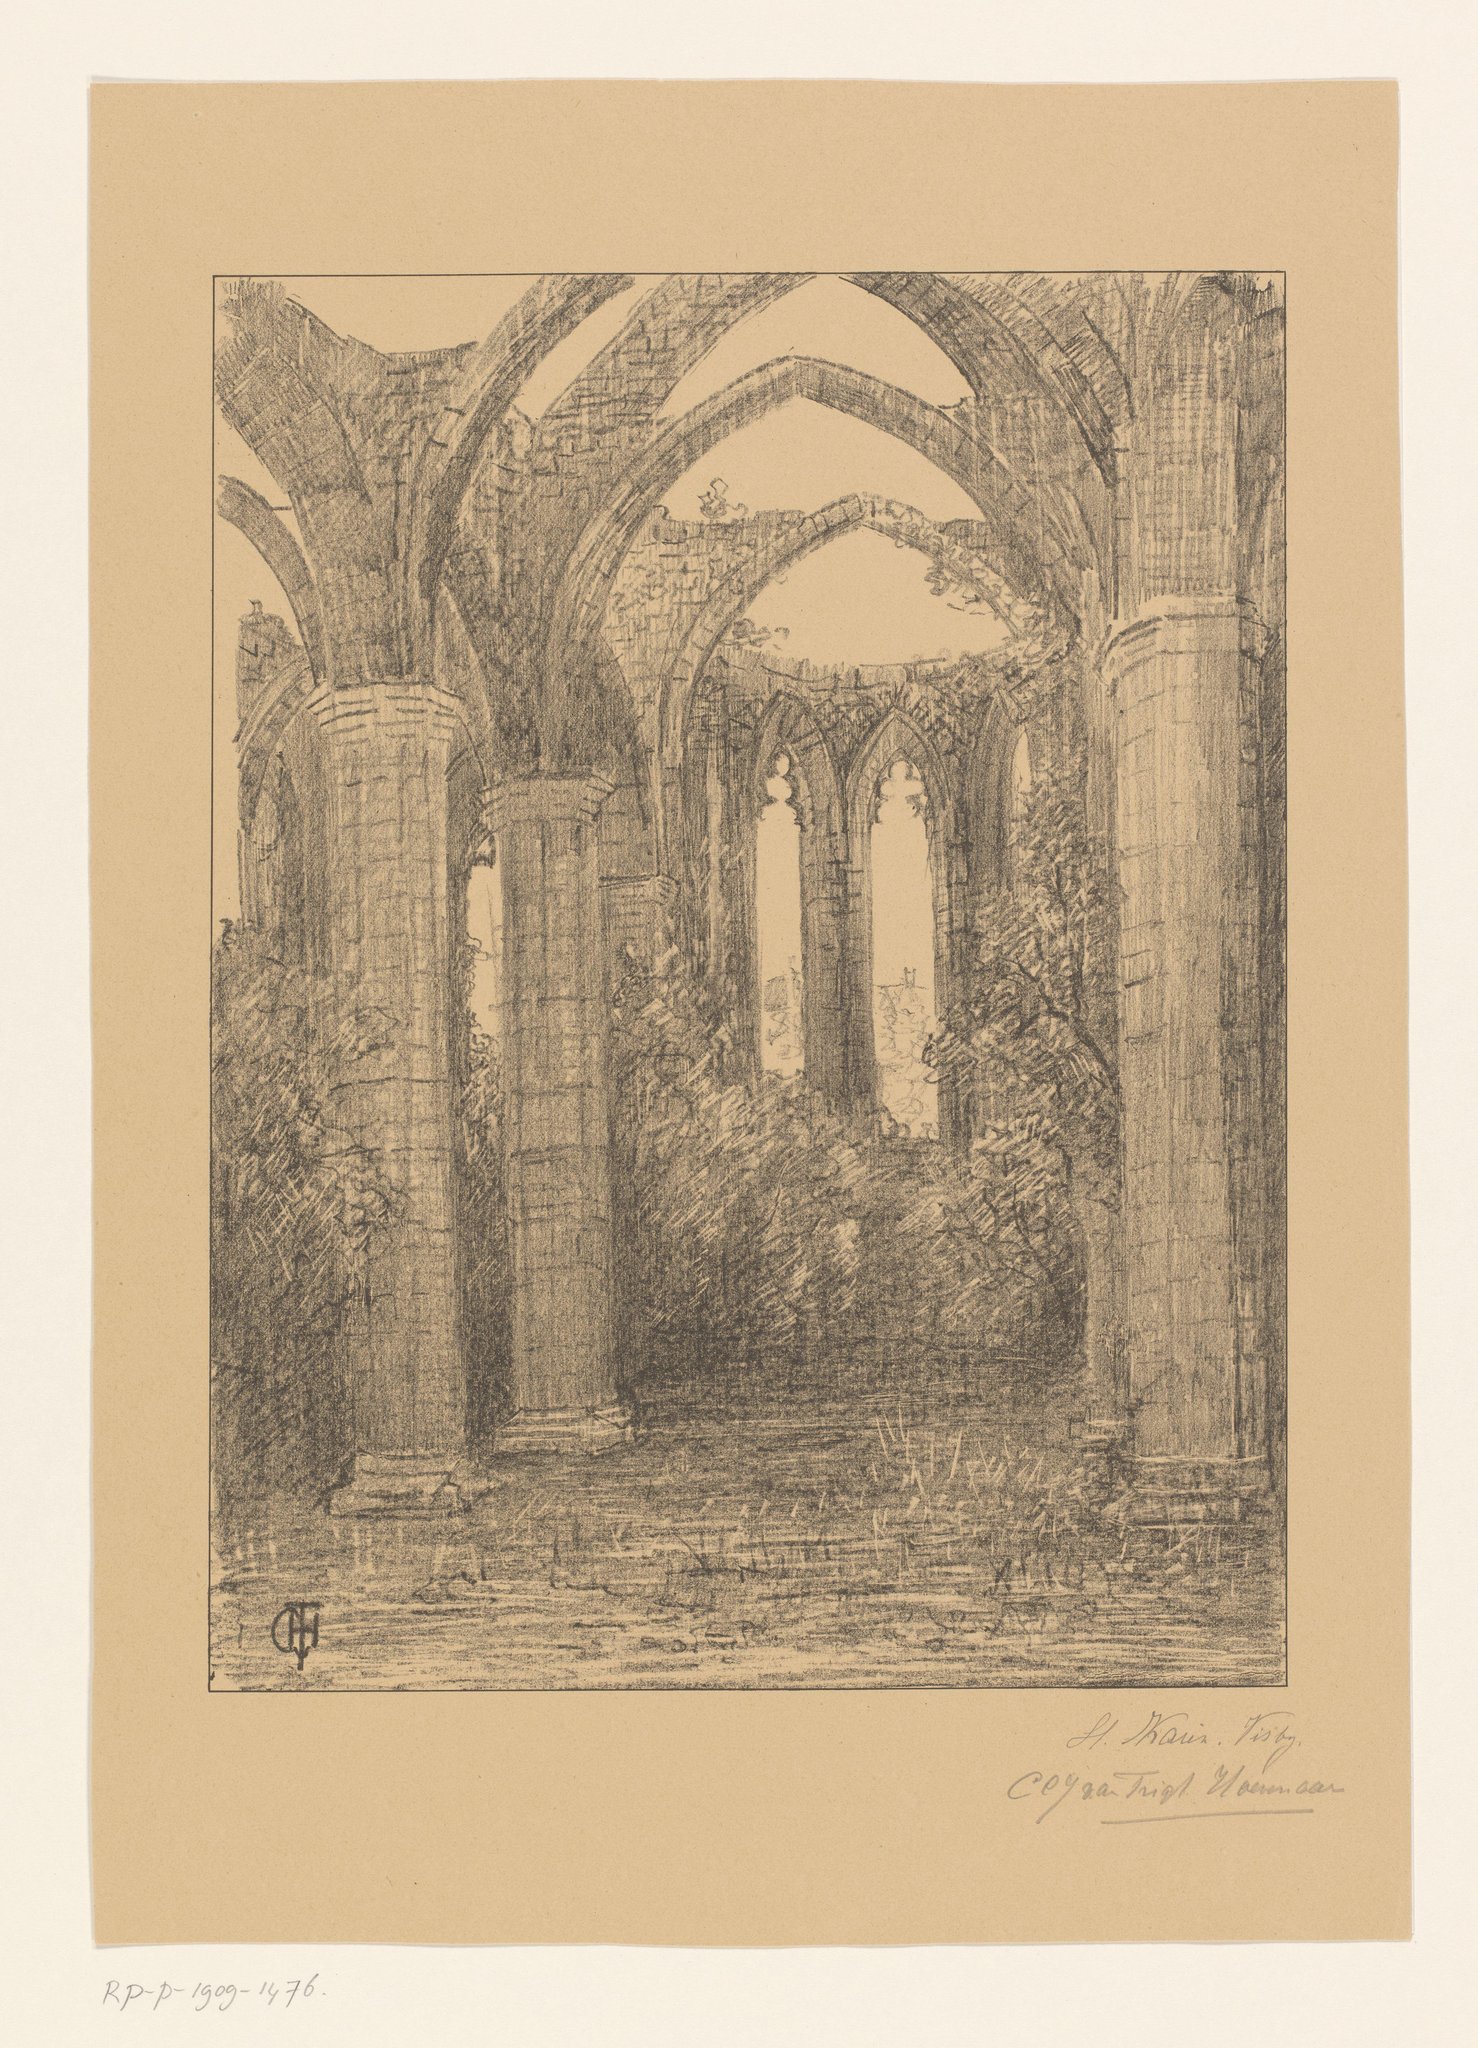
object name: print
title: Ruïne van San Karin op Visby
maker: cornelia christina johanna van trigt-hoevenaar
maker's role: print maker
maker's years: 1854-1924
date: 1864-1909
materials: paper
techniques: lithograph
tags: ruin of church, monastery, etc.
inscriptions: collector's mark: Lugt 2228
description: Gezicht op het overwoekerde koor vanuit het middenschip waarvan het dak ontbreekt.